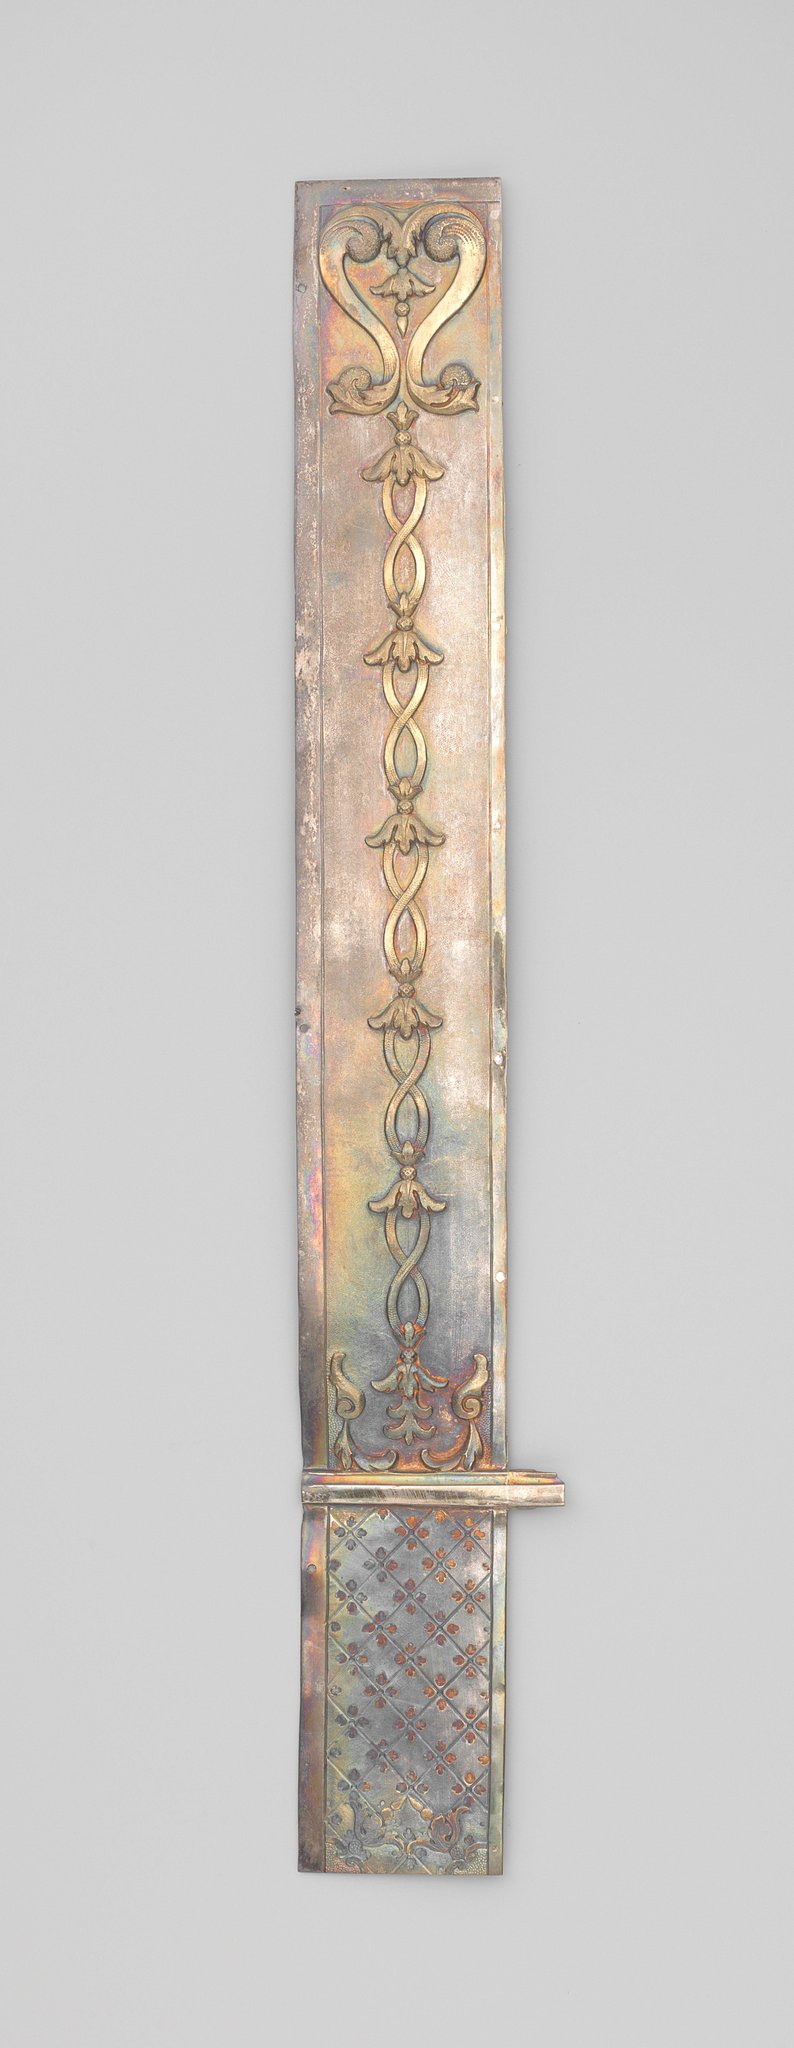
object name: tabernakeldeur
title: Strip van zilver van een tabernakeldeur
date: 1756-1757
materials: silver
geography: london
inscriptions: mark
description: Strip van zilver dat aan de zijkant van het tabernakeldeurtje hoort. Het is versierd met Lodewijk XIV-ornamenten.